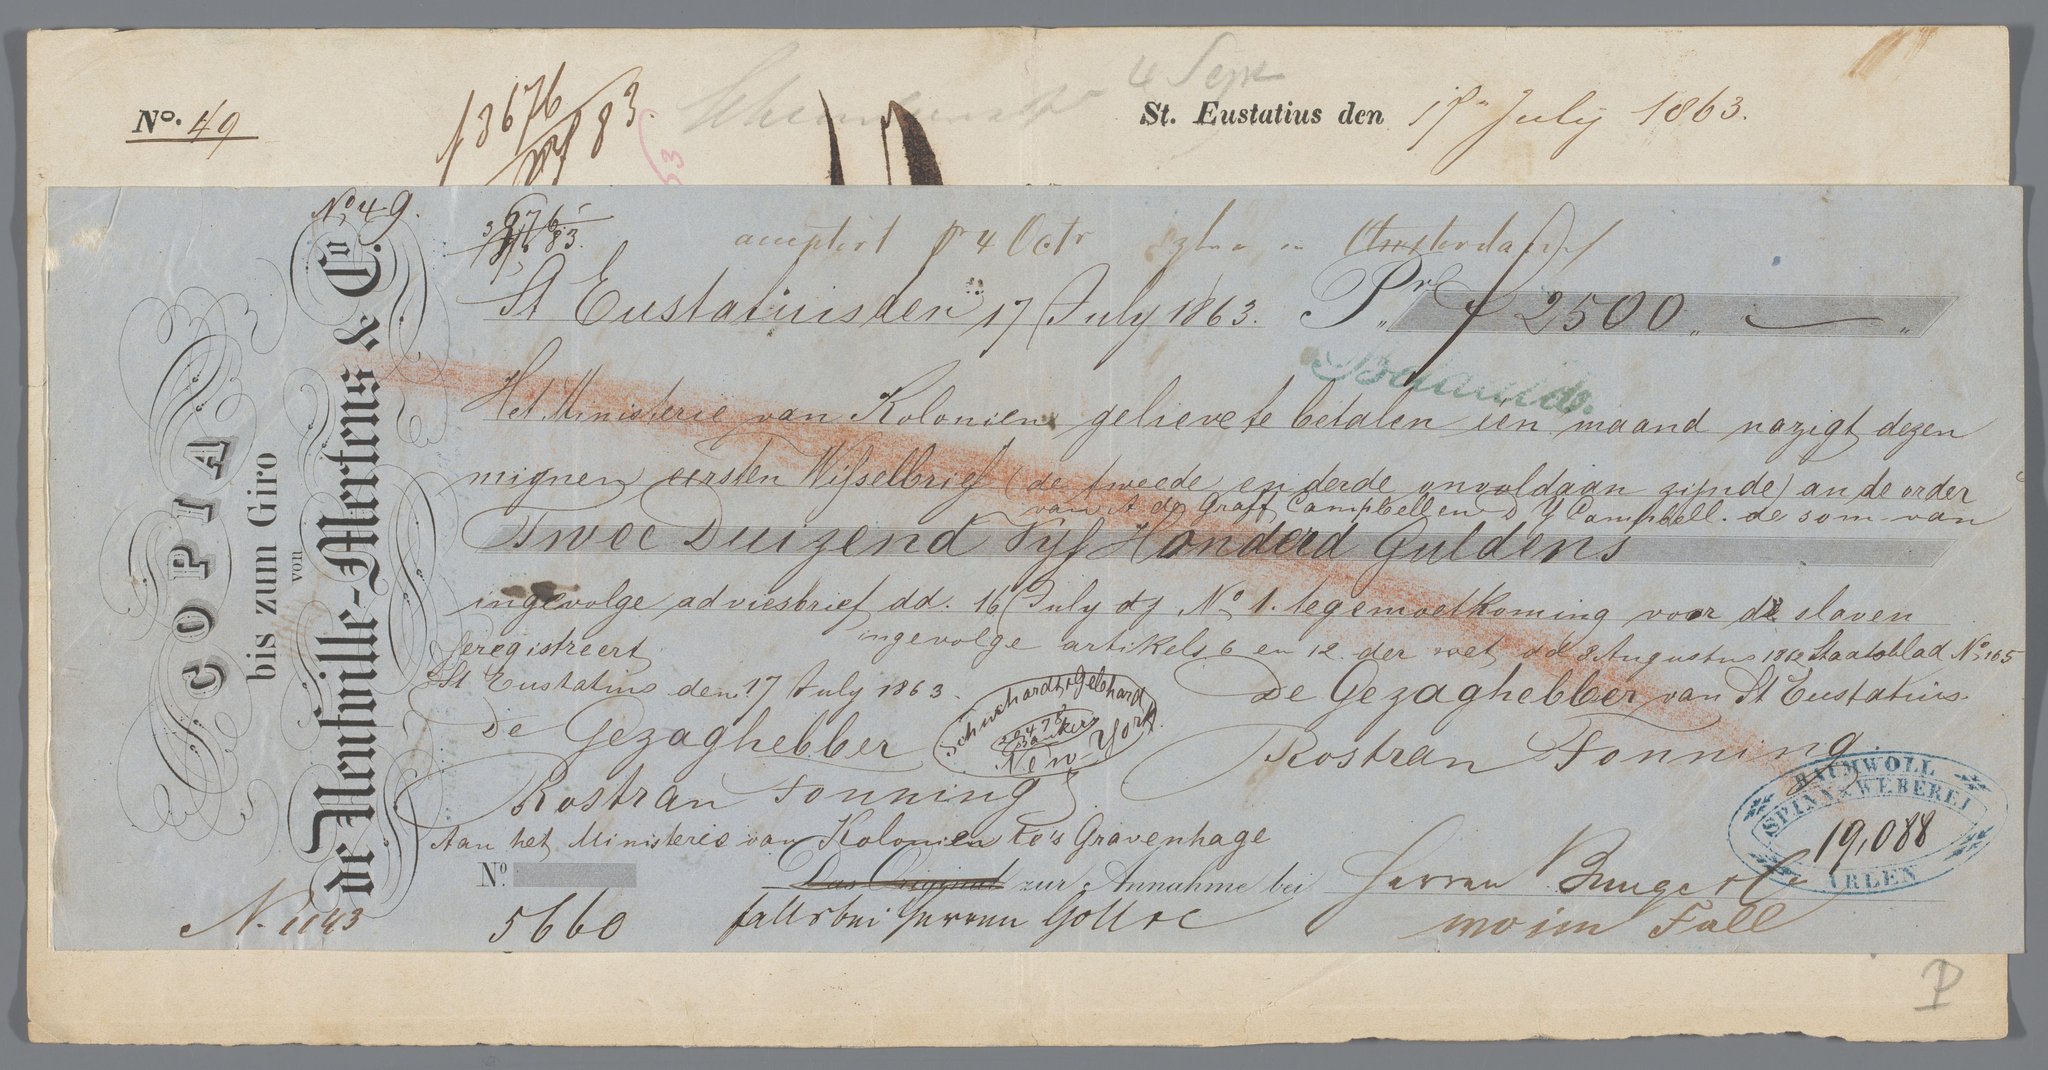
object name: ontvangstbewijs, kwitantie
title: Wisselbrief voor A. de Graaff Campbell en D.Y. Campbell, slavenhouders op Sint Eustatius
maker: Anonymous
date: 1863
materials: ink, paper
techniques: printing, writing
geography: netherlands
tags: slavery; serfs and enslaved persons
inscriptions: date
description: Wisselbrief ter waarde van 2500 gulden ten name van A. de Graaff Campbell en D.Y. Campbell, 17 juli 1863. Wisselbrief uitgegeven aan slavenhouders op Sint Eustatius om deze bij de Emancipatie van 1863 te compenseren voor het vrij verklaren van de tot slaaf gemaakte mensen die zij tot hun bezit rekenden. Met aangehechte kopie.